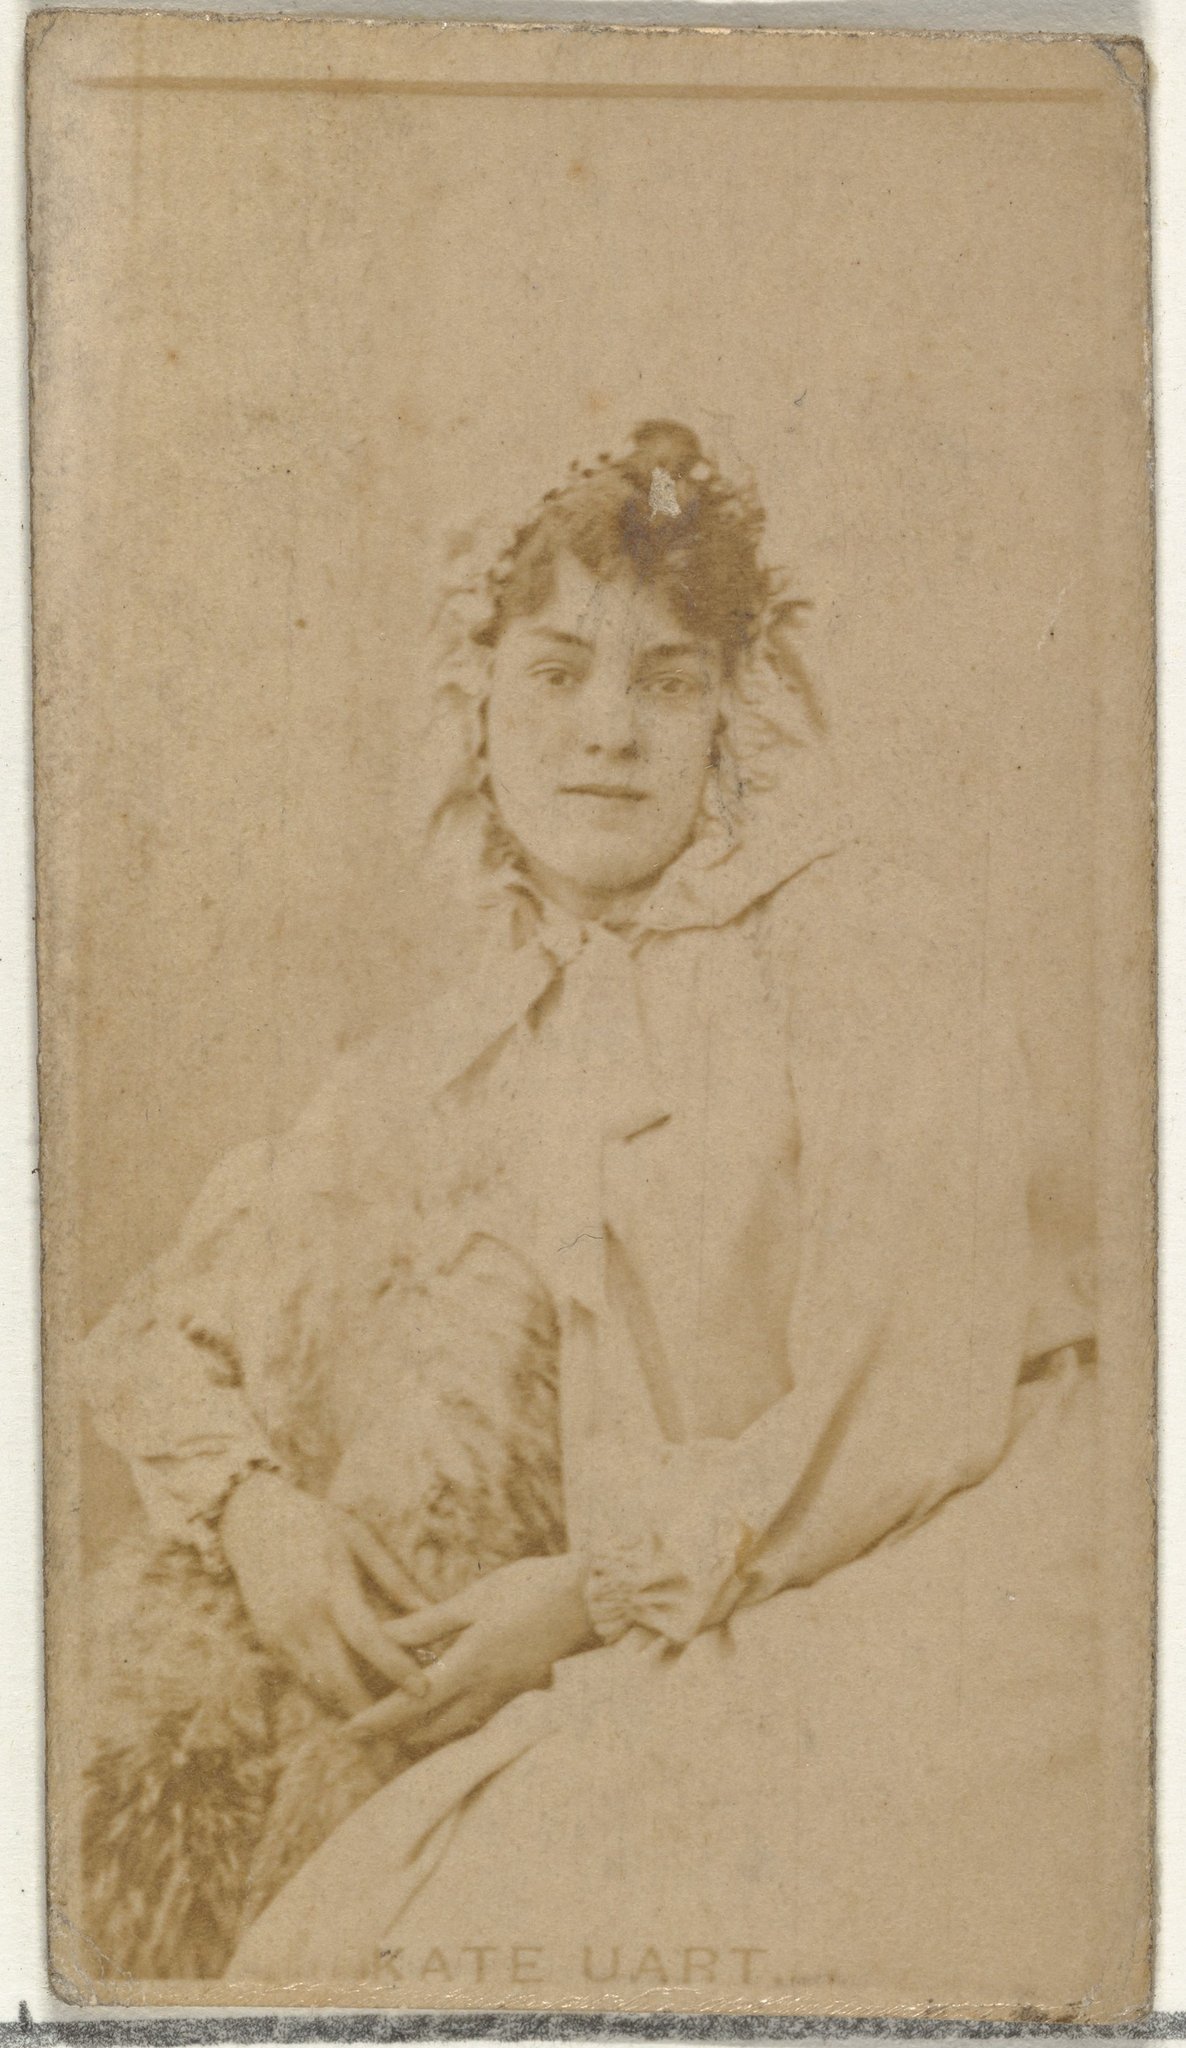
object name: photograph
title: Kate Uart, from the Actors and Actresses series (N145-8) issued by Duke Sons & Co. to promote Duke Cigarettes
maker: w. duke, sons & co.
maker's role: publisher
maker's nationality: american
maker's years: 1870-1920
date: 1891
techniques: albumen silver print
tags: portraits,women,actresses